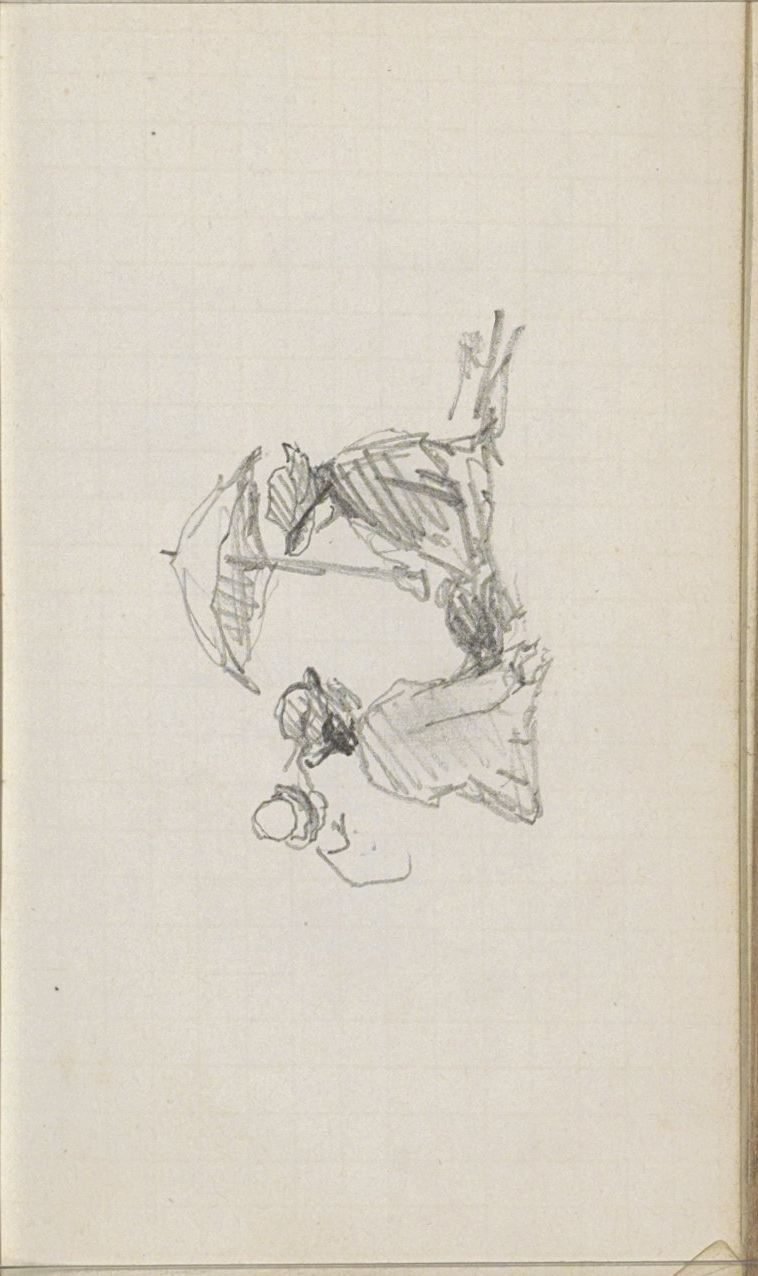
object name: sketchbook leaf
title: Twee zittende vrouwen onder een parasol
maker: jan willem van borselen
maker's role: draughtsman, print maker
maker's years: 1825-1892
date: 1868-1887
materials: pencil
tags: sitting figure - aa - female human figure, parasol, sunshade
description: Blad 35 recto uit een schetsboek met 51 bladen.